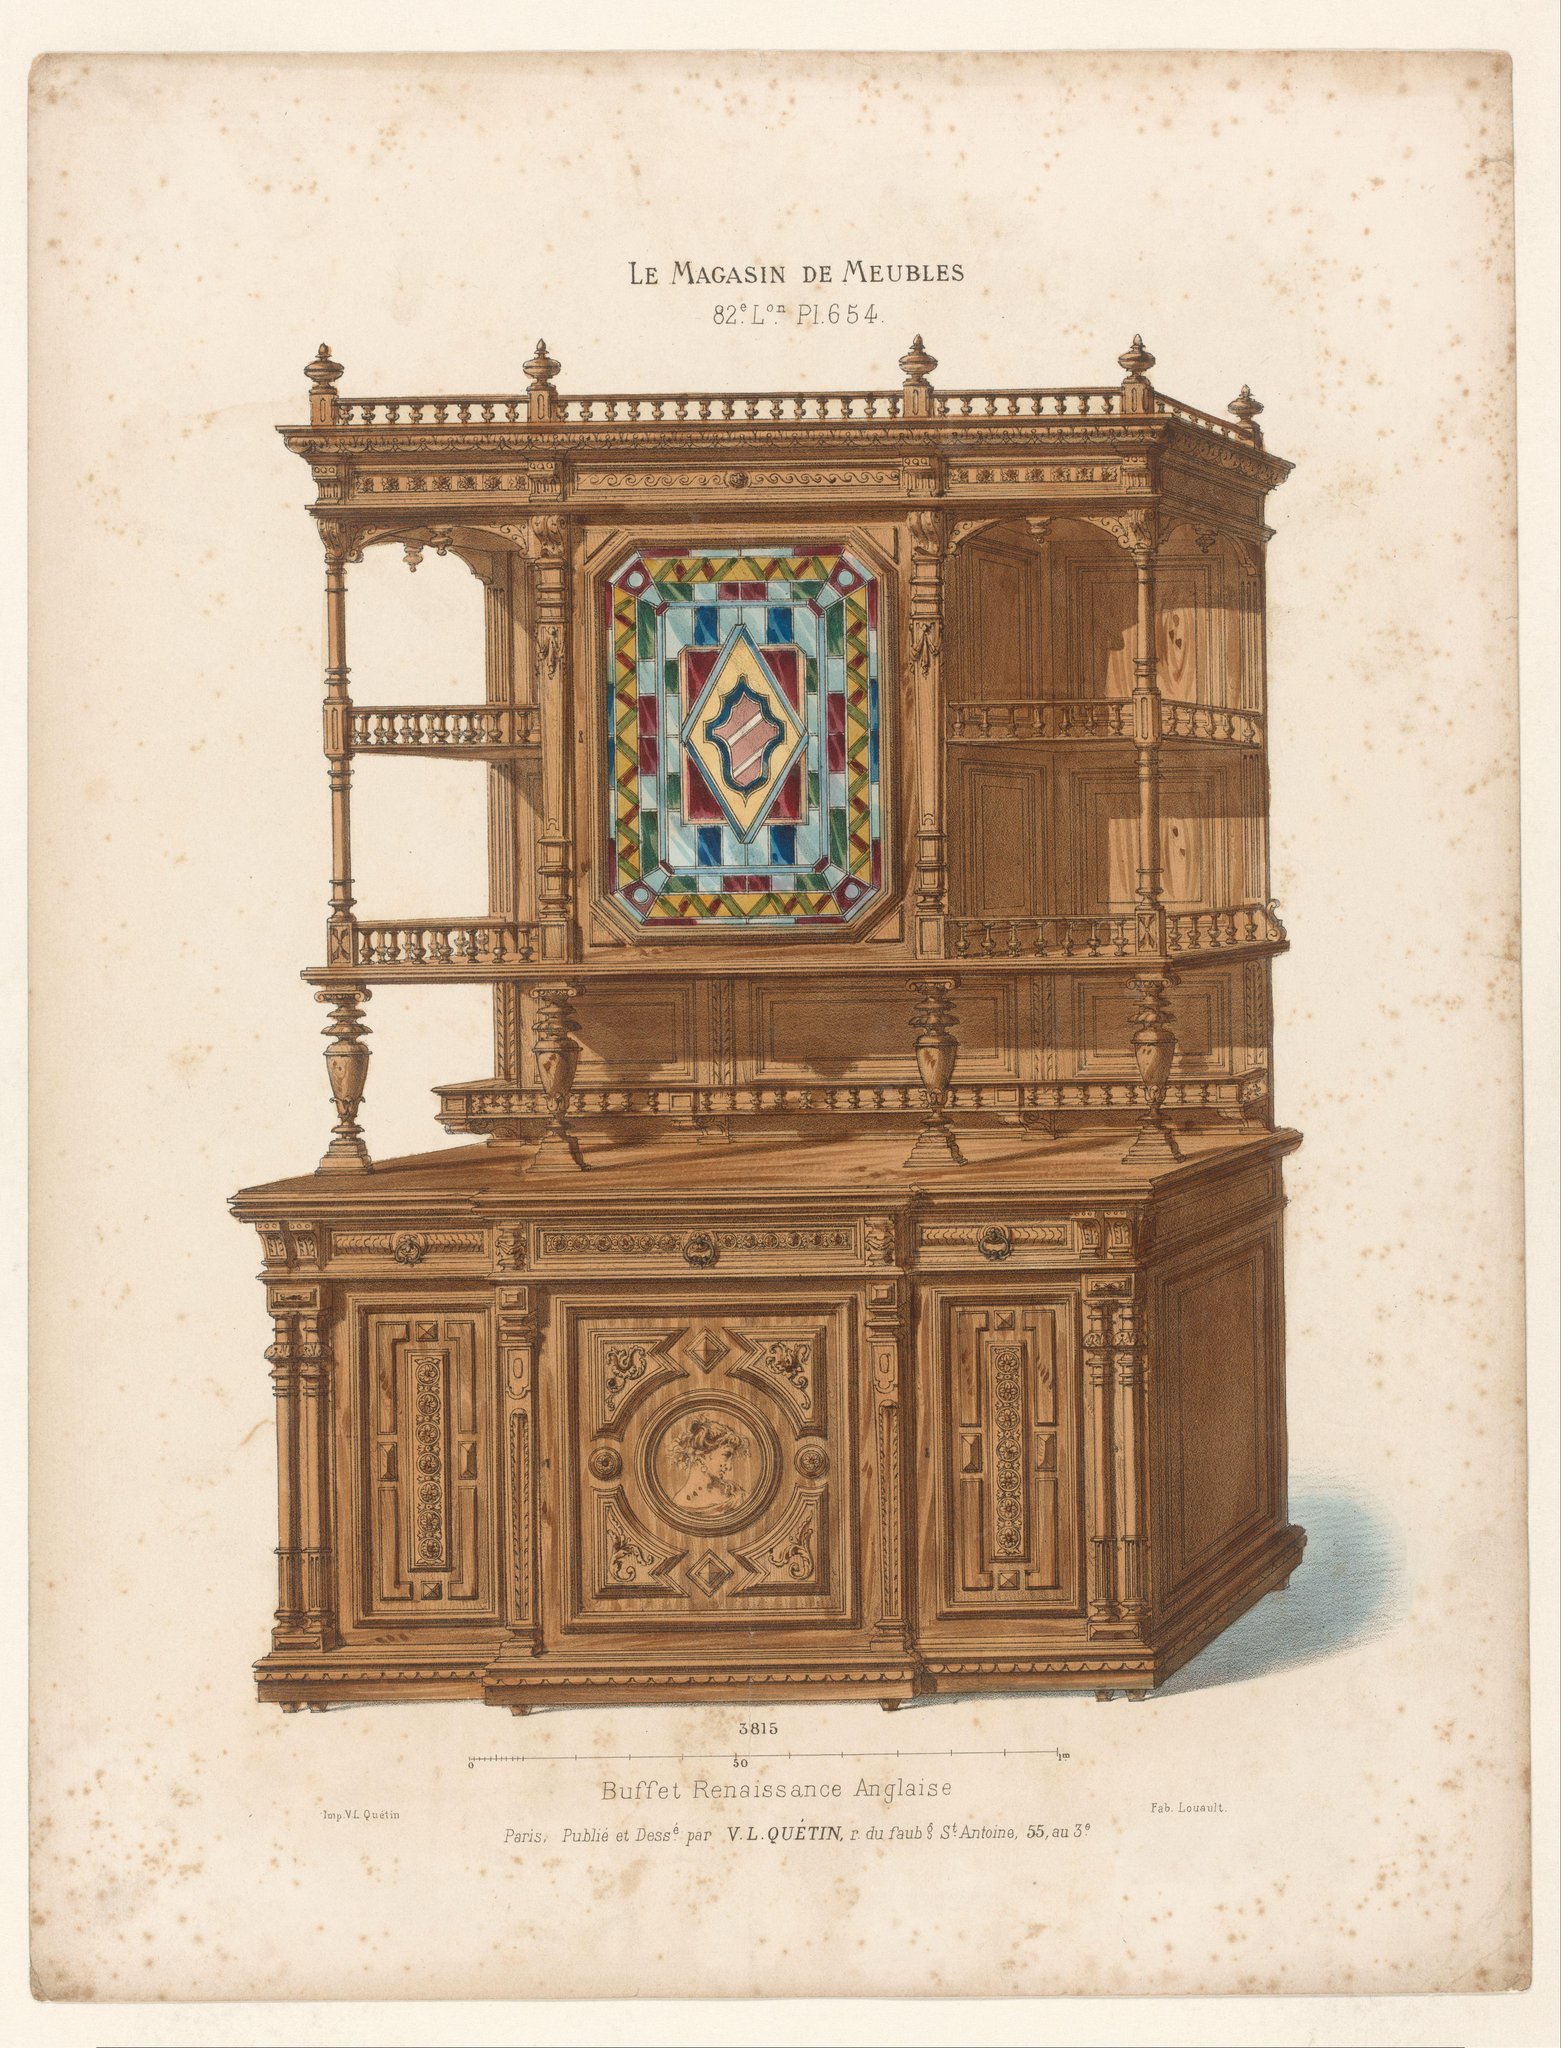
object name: print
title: Buffet Renaissance Anglaise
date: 1878-1904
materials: paper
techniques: hand coloring, lithograph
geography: paris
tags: furniture for storage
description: Een renaissance buffetkast. Prent uit 82e Livraison.